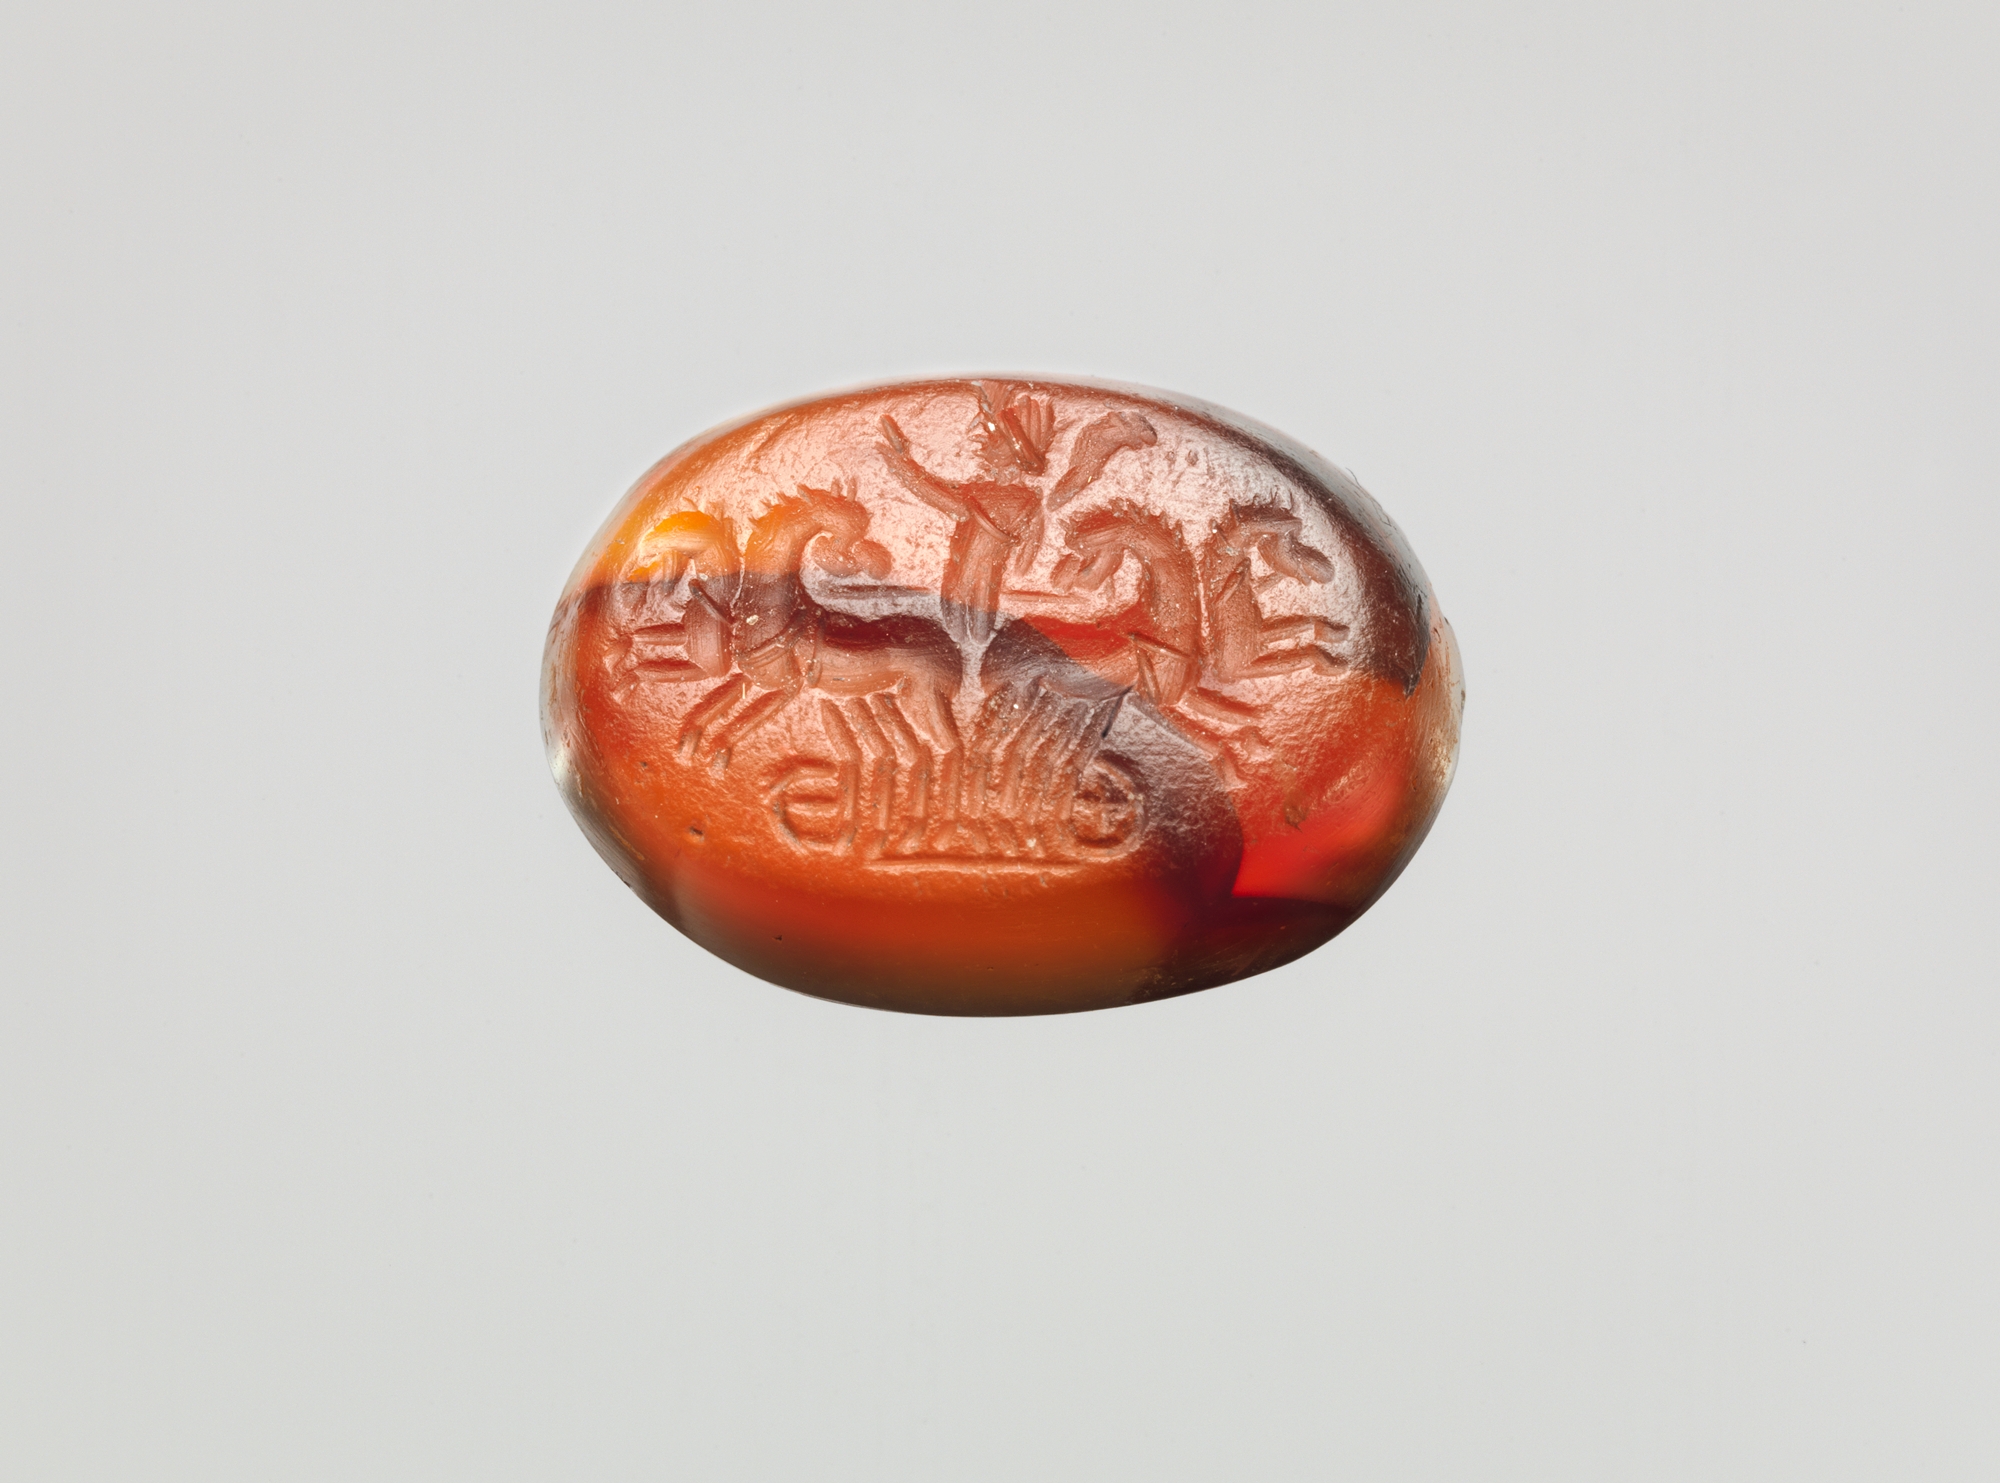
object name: intaglio, magical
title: Carnelian intaglio: Sol in a quadriga (four-horse chariot)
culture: roman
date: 200 BCE-200 CE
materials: gemstone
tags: men,horses,chariots